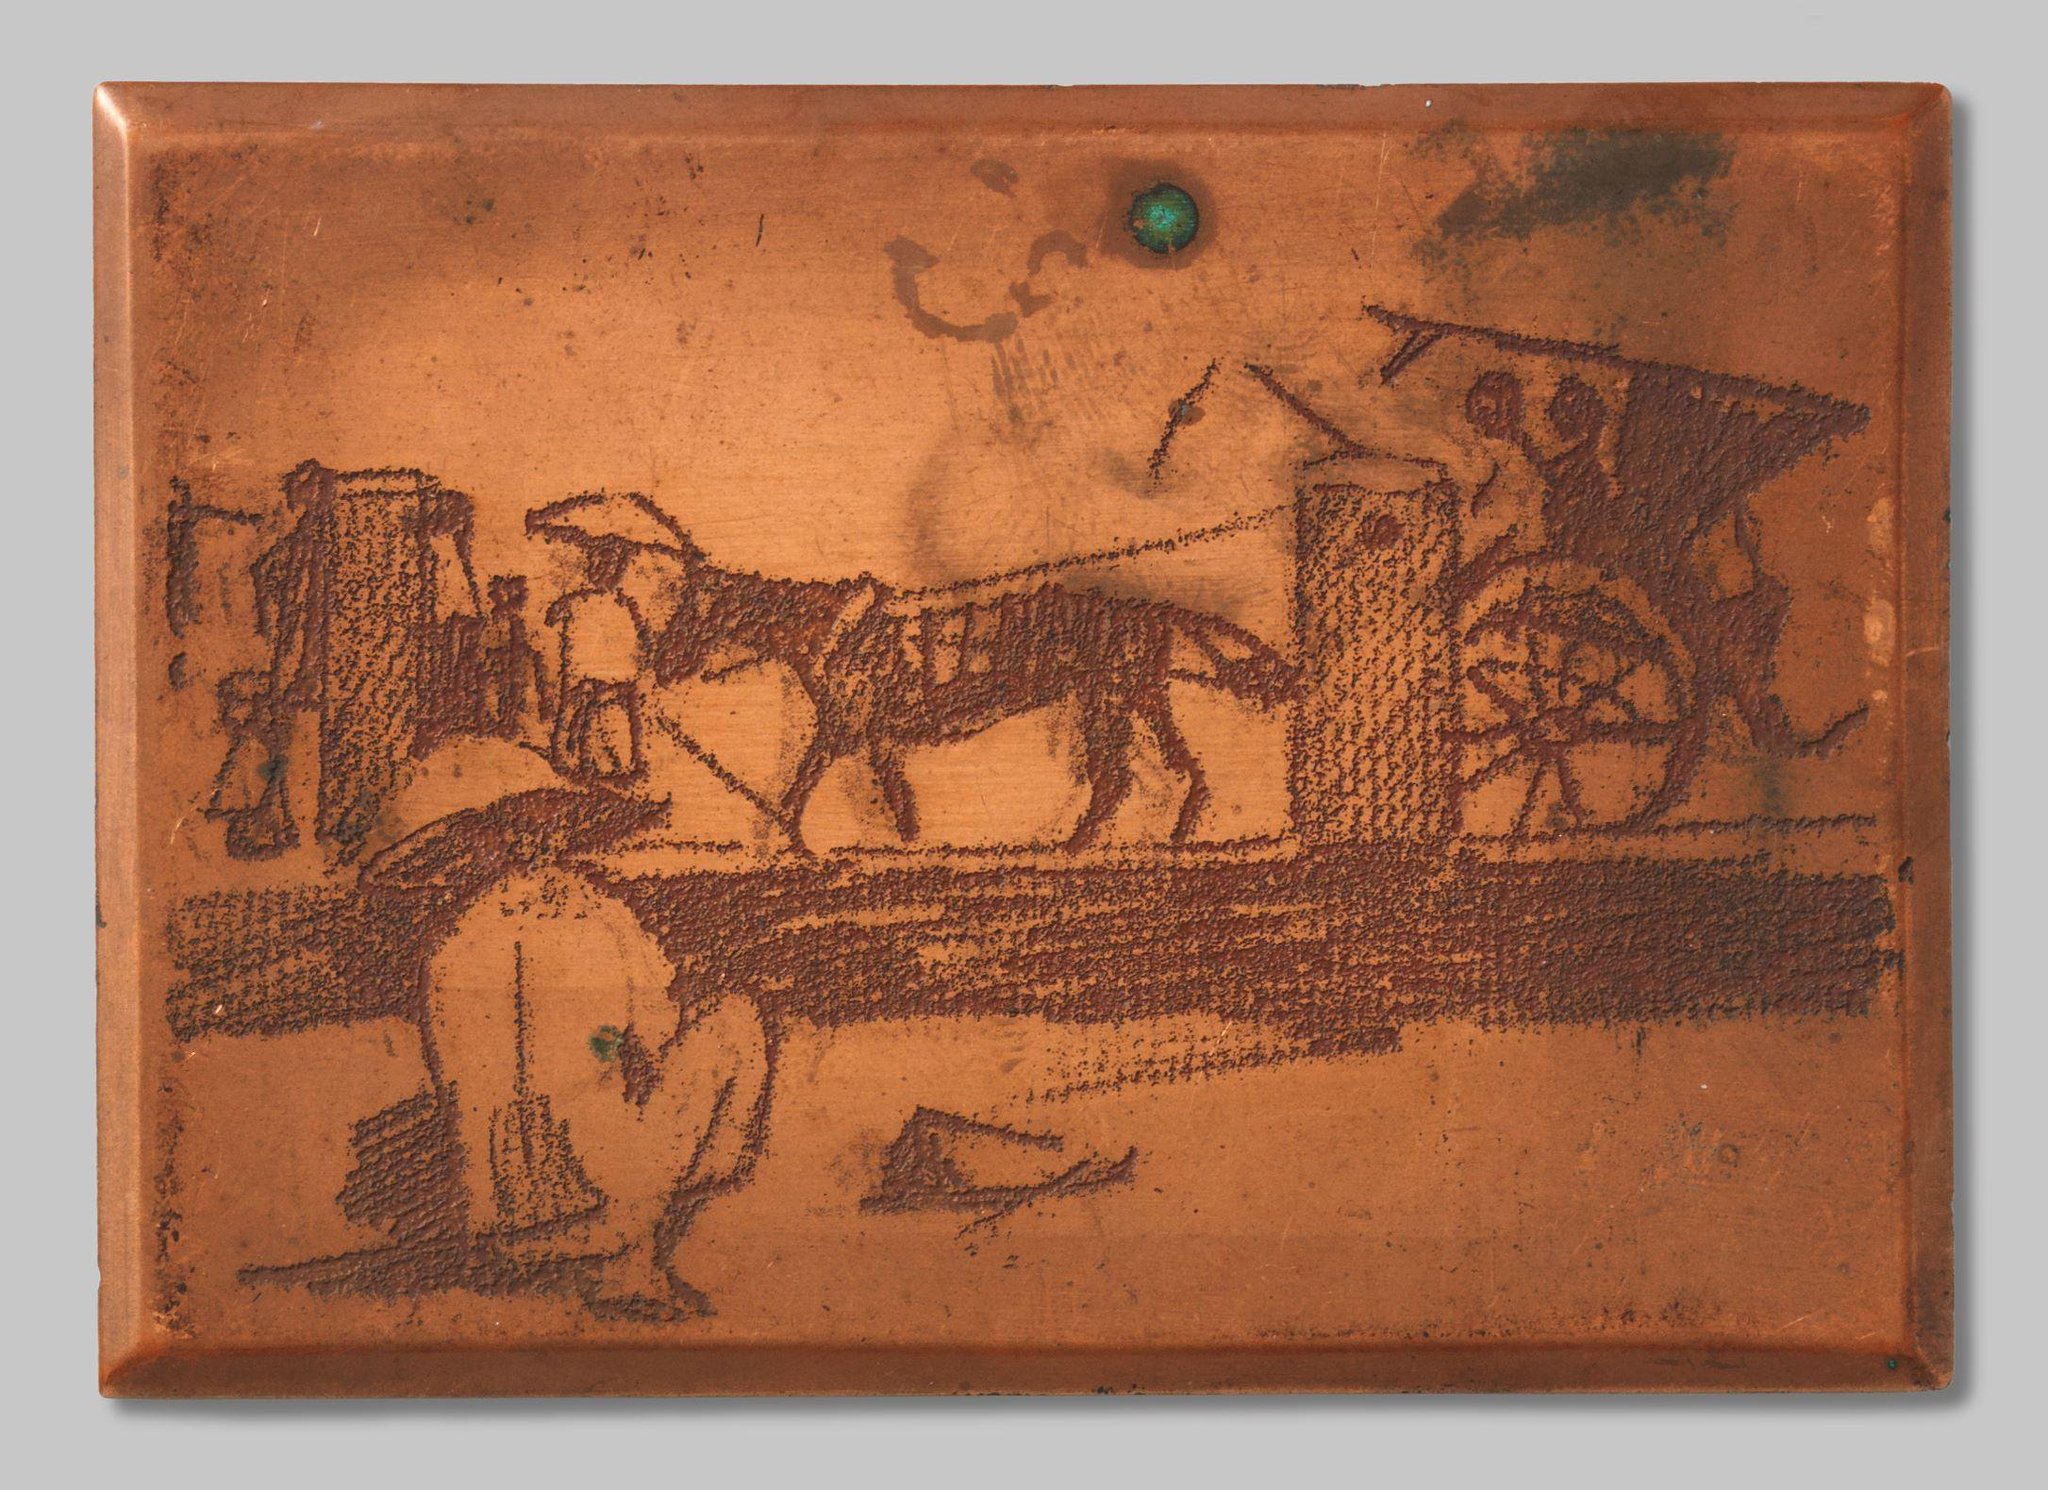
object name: copper plate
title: Sadotje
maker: willem witsen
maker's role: draughtsman, painter, print maker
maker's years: 1860-1923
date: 1921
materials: copper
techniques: soft ground etching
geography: buitenzorg